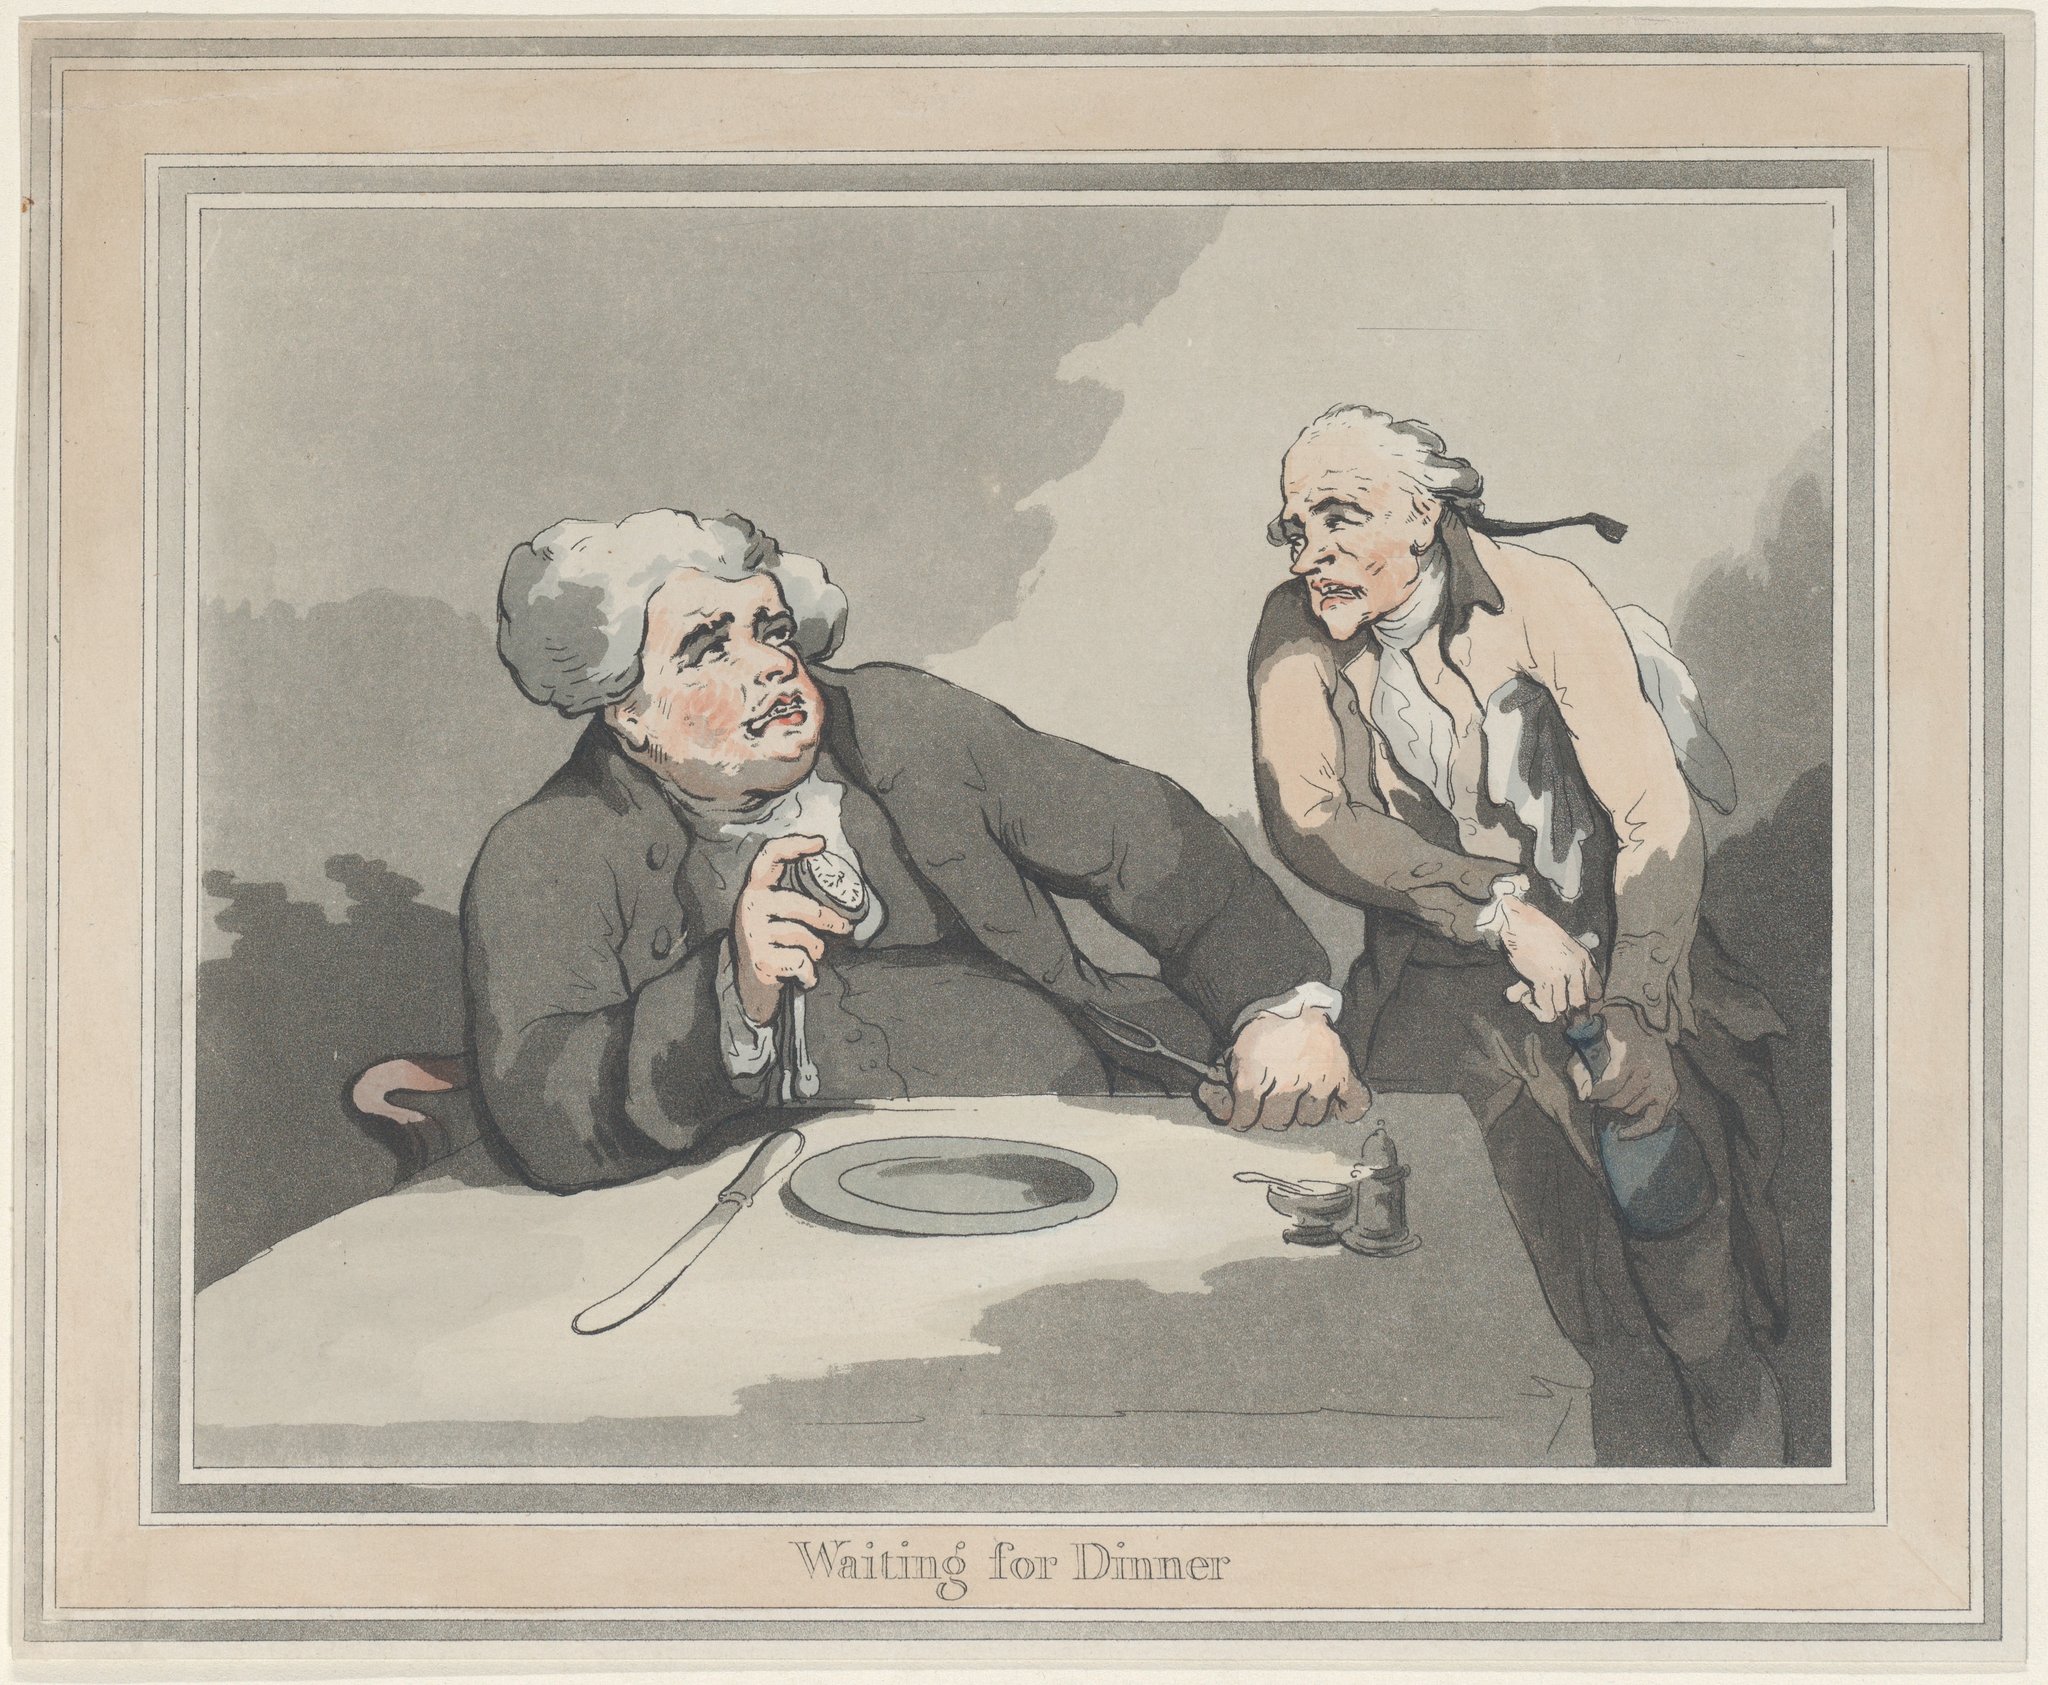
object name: print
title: Waiting for Dinner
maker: thomas rowlandson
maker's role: artist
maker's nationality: british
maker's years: 1757-1827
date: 1790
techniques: aquatint, etching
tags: satire,men,dining